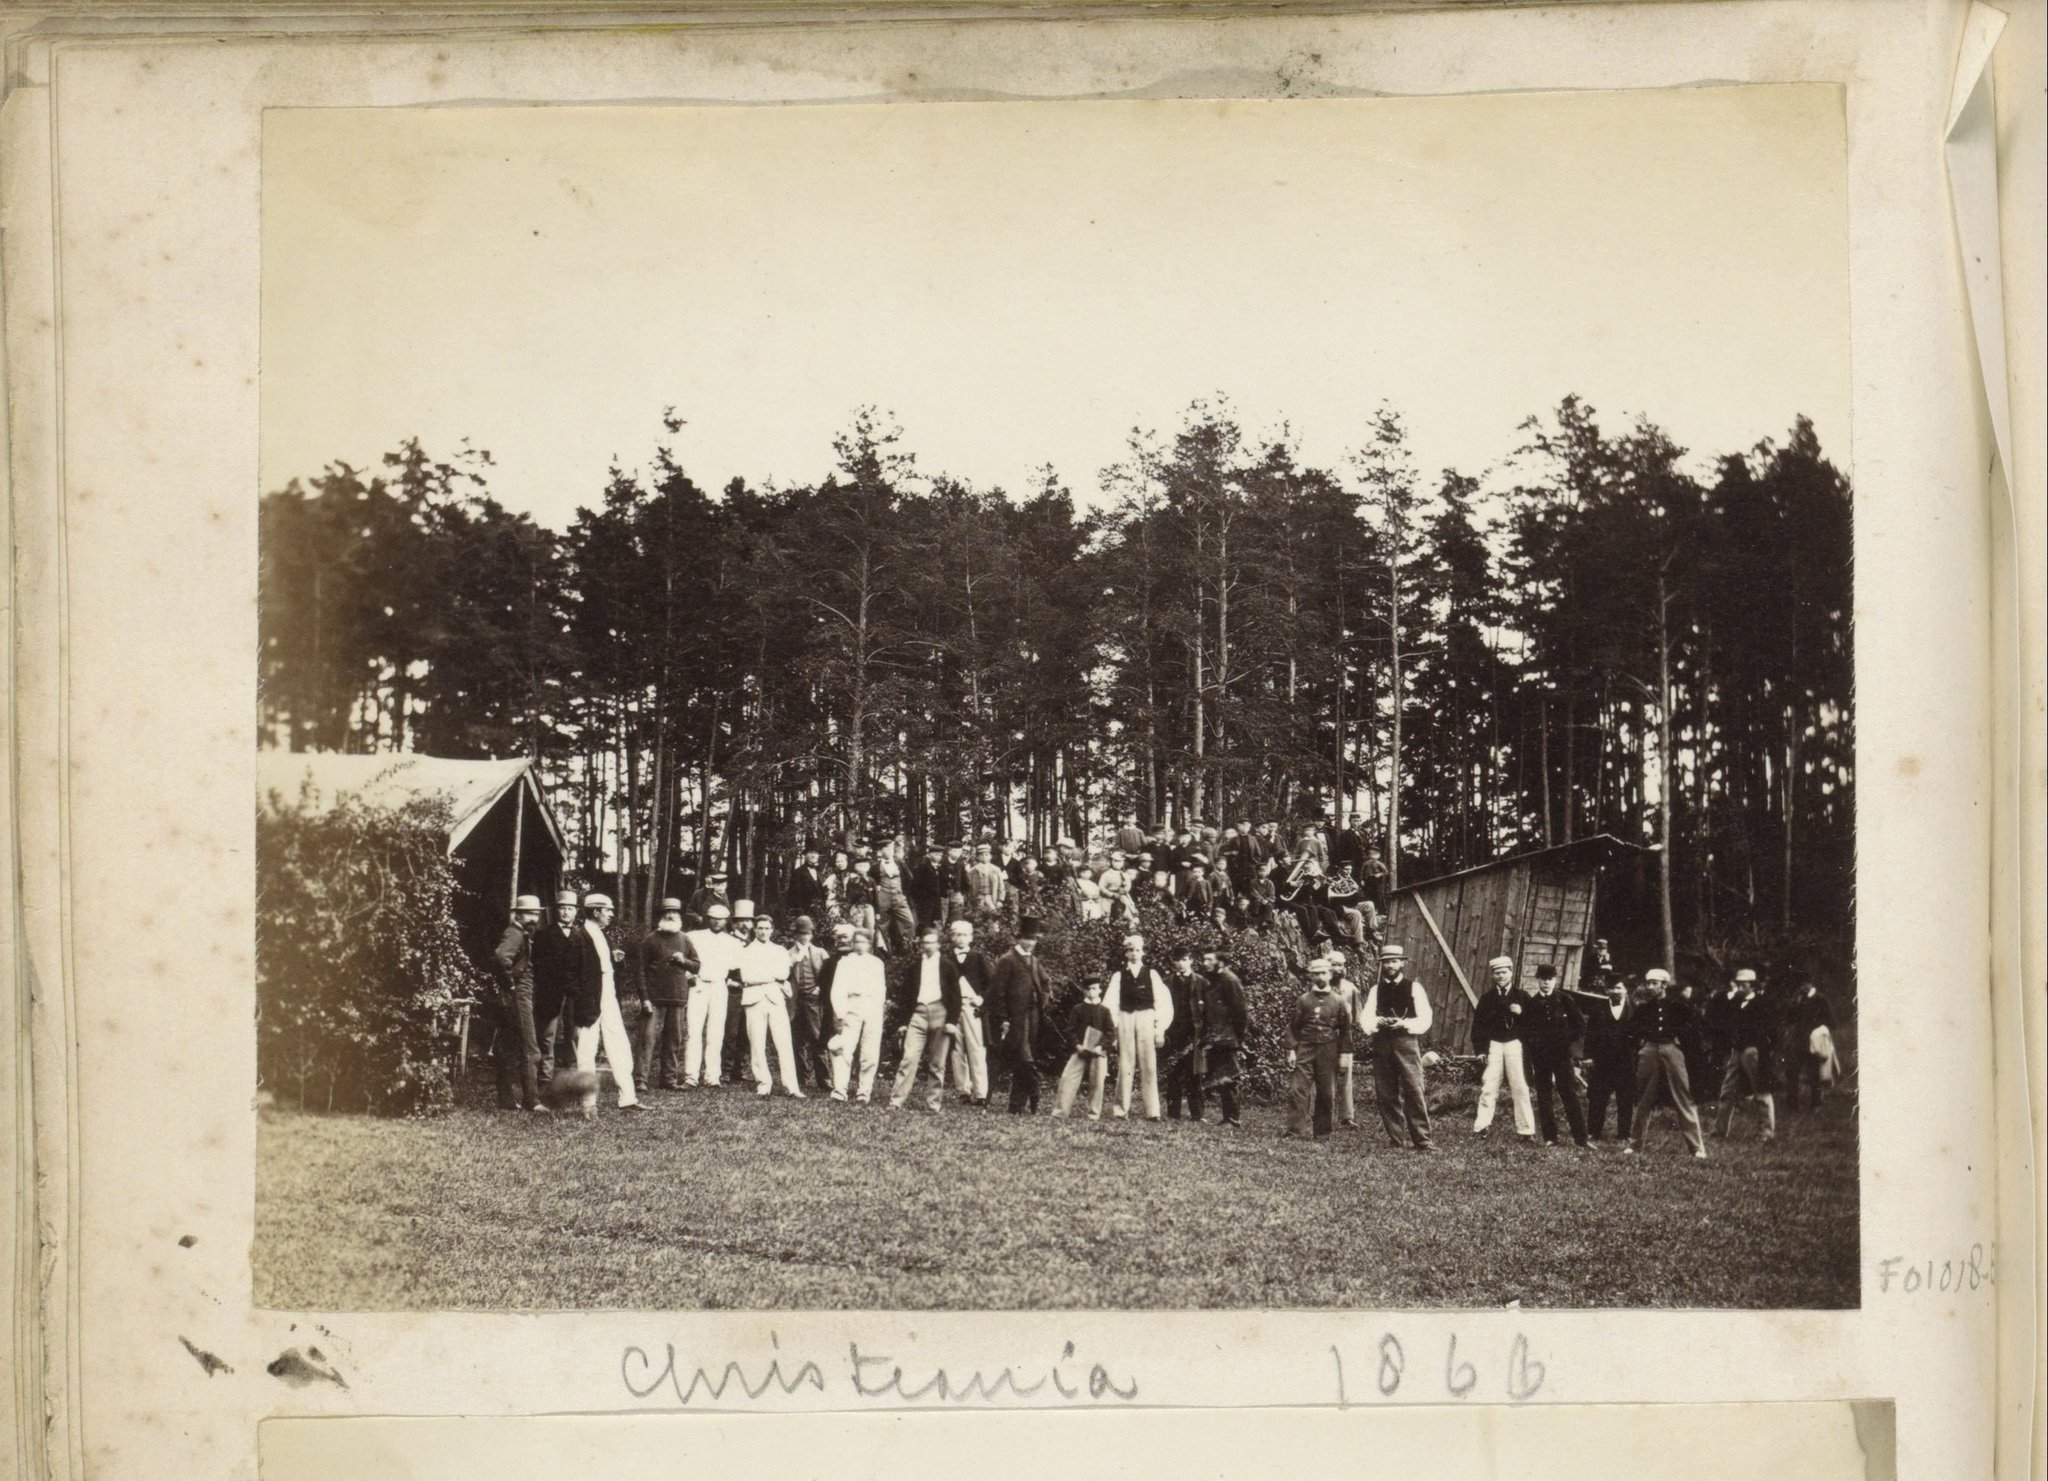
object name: photograph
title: Groepsportret van cricketspelers bij een tent in Christiania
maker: Anonymous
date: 1866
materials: paper, photographic support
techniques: albumen print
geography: christiania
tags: trees, adult woman, clothing for the lower part of the body, tent, cricket (ball game), head-gear, adult man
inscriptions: inscription: ‘Christiania 1866’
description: Onderdeel van Engels familiealbum met foto's van personen, reizen, cricket en kunstwerken.